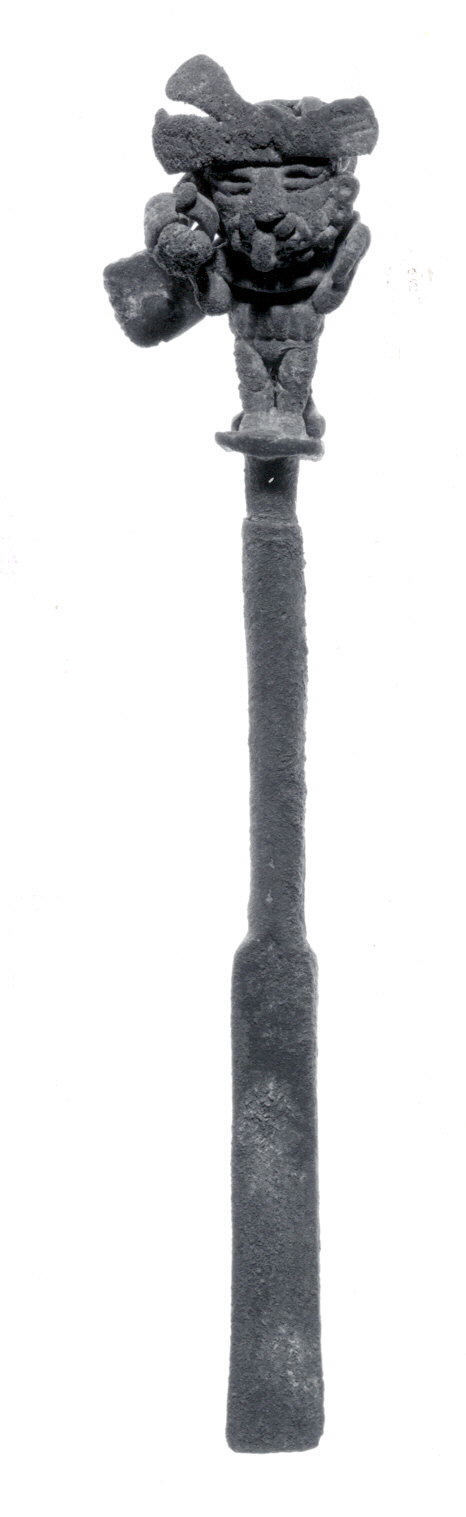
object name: knife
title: Knife with Masked Figure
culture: moche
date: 101-700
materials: copper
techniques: casting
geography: peru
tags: human figures